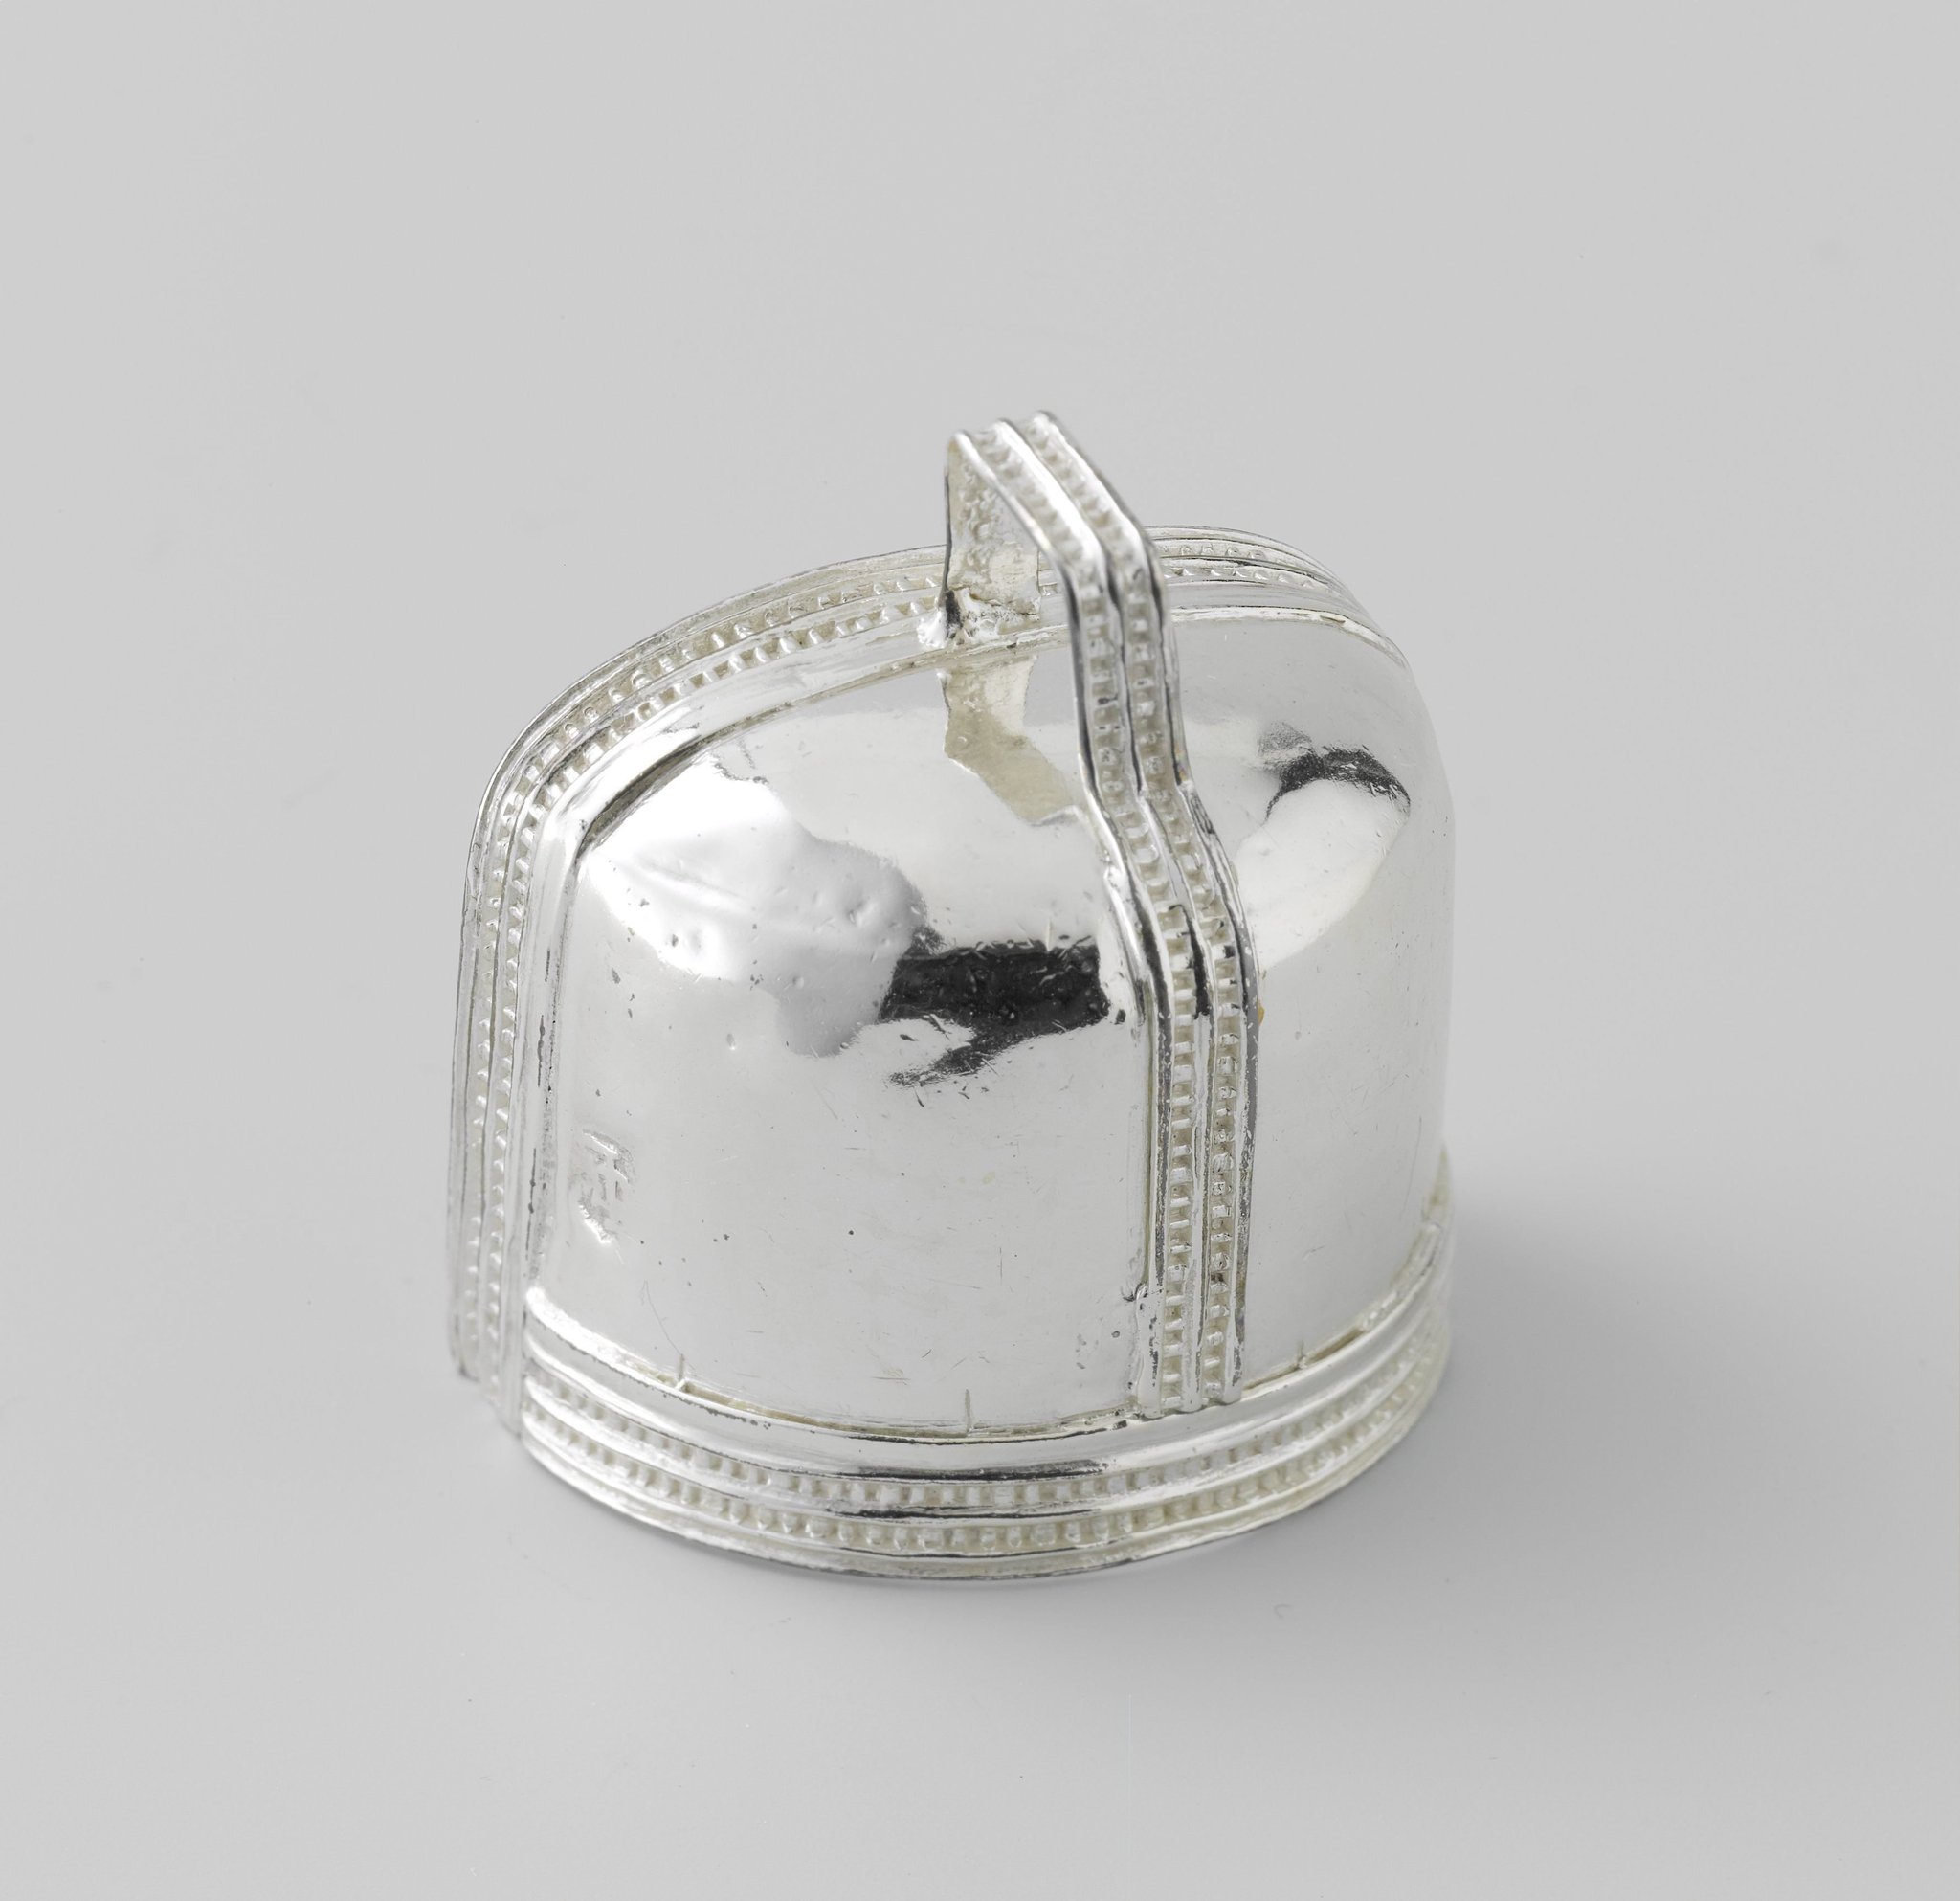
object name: miniature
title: Vuurstolp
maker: jacob dijckman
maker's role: silversmith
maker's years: 1644-1719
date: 1671-1716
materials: silver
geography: amsterdam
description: Halfronde vuurstolp met een handvat dat aan de voorzijde van de stolp doorloopt als een opgelegde band. De randen en het handvat zijn bewerkt. De stolp is aan de voorzijde gemerkt: mt.= JD en de letter J. Aan de binnenzijde is het monogram AWS en AH gegraveerd.